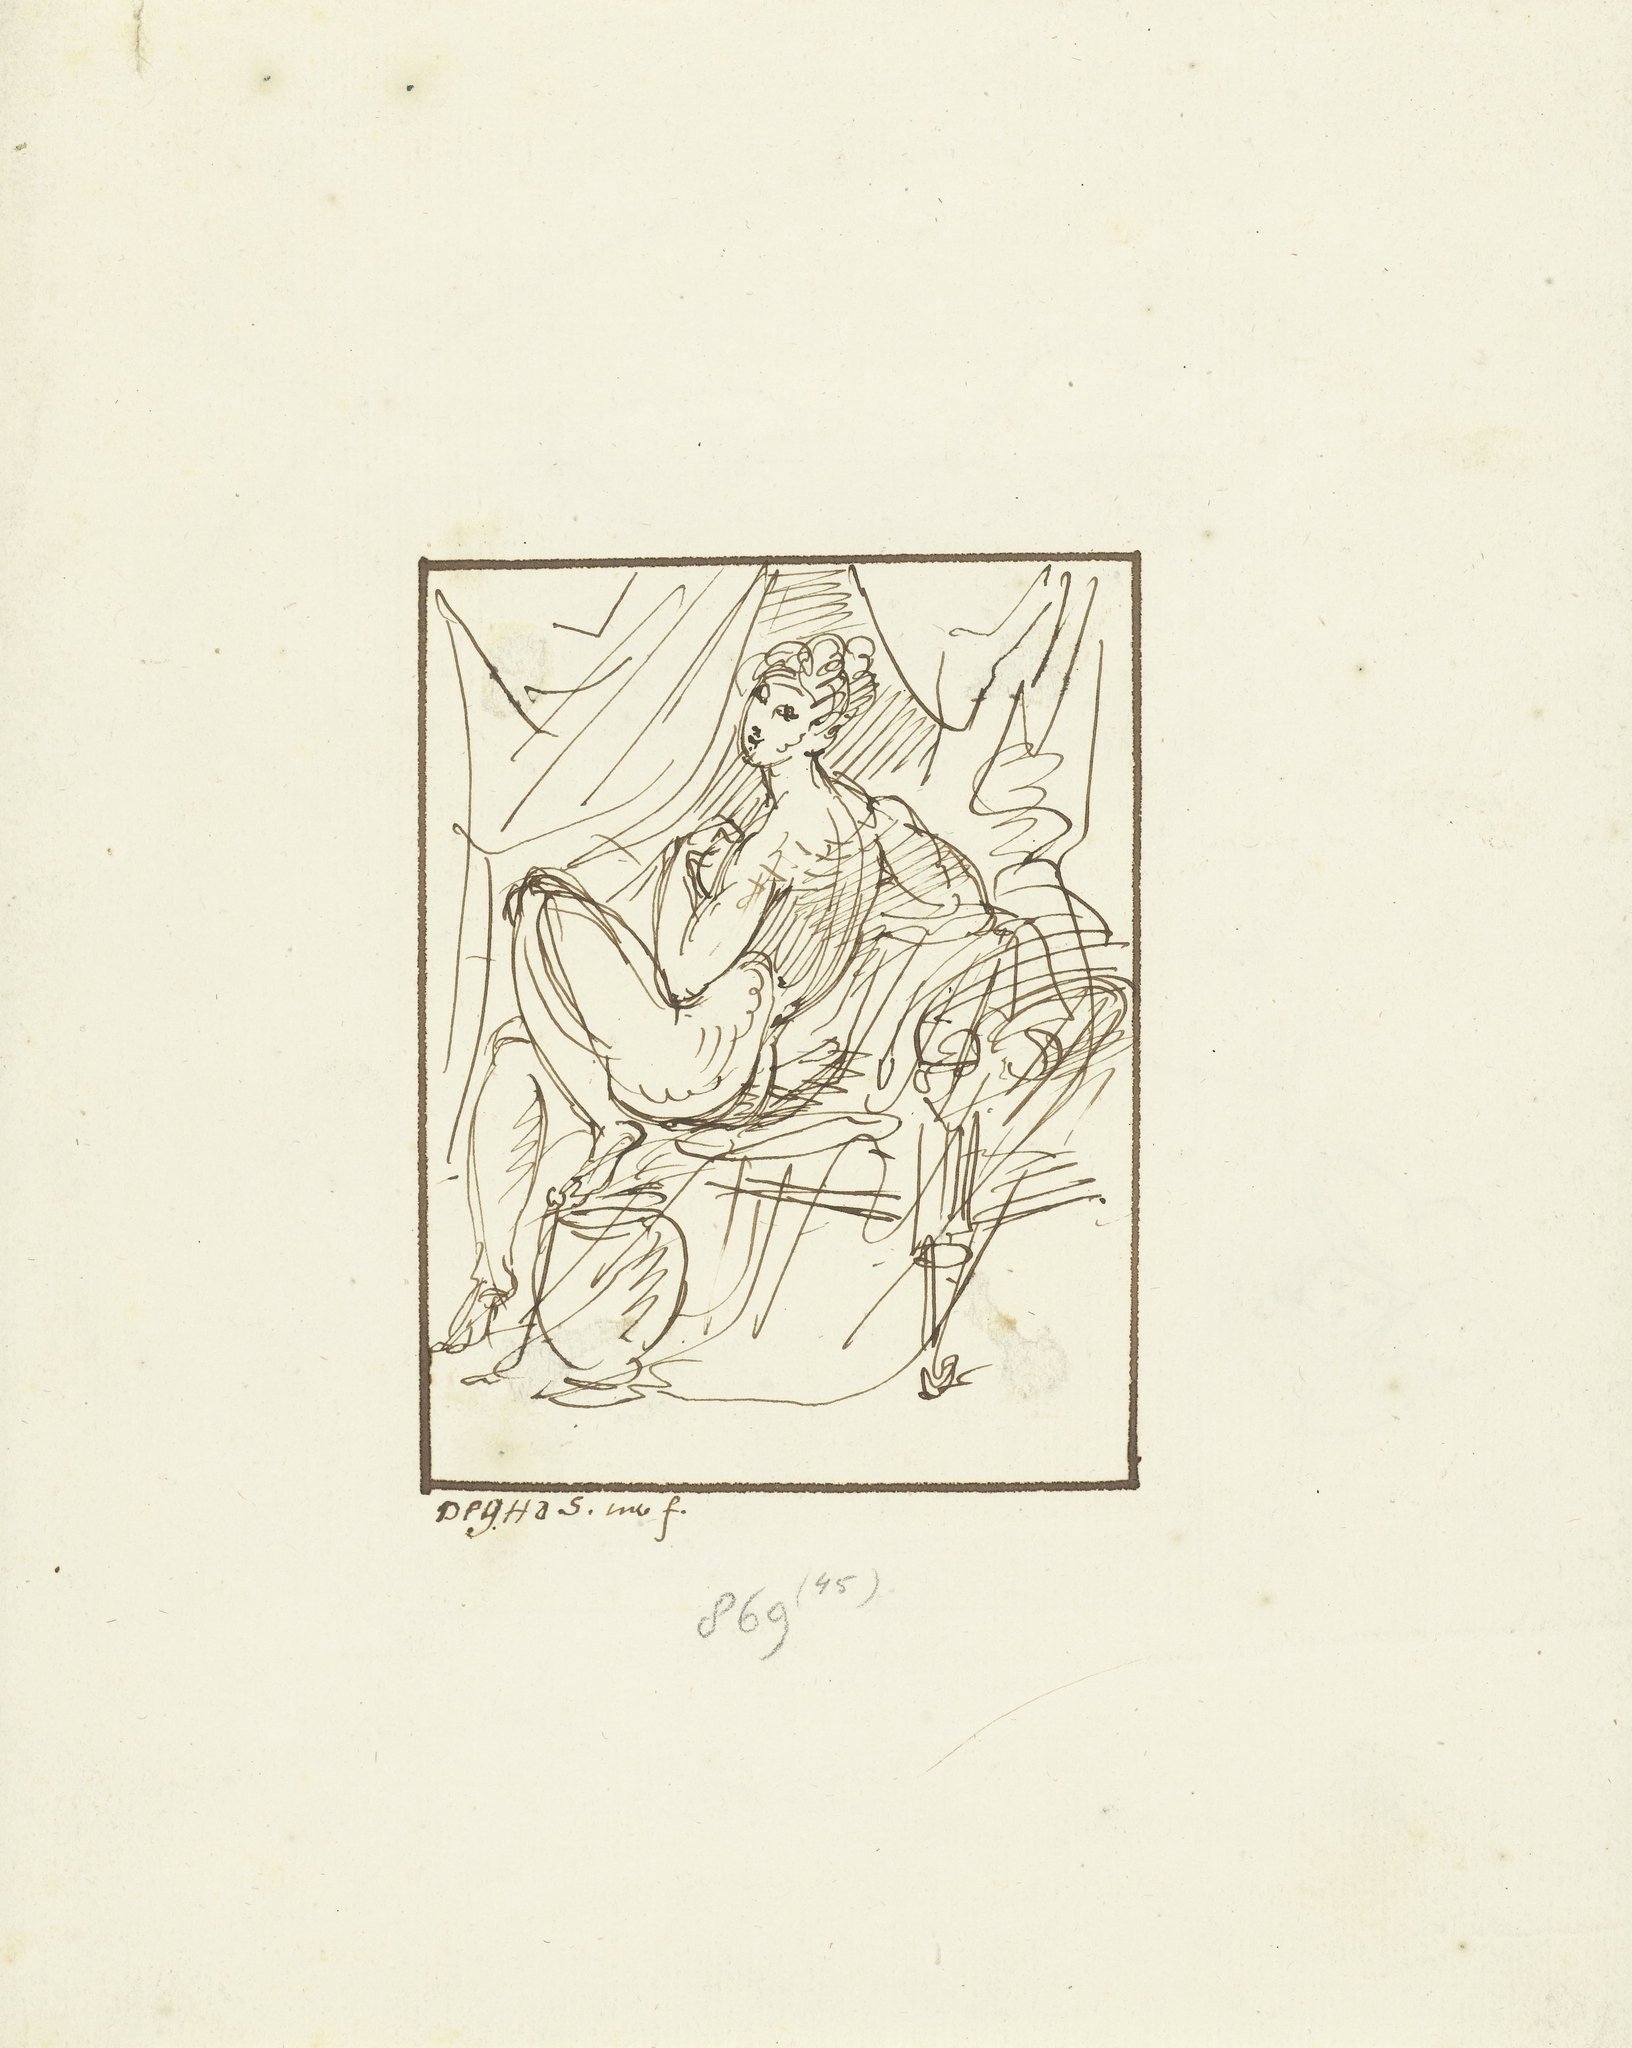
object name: drawing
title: Vrouw op chaise-longue zittende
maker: david pièrre giottino humbert de superville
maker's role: draughtsman, painter, print maker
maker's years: 1770-1849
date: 1780-1849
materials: ink, paper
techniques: pen